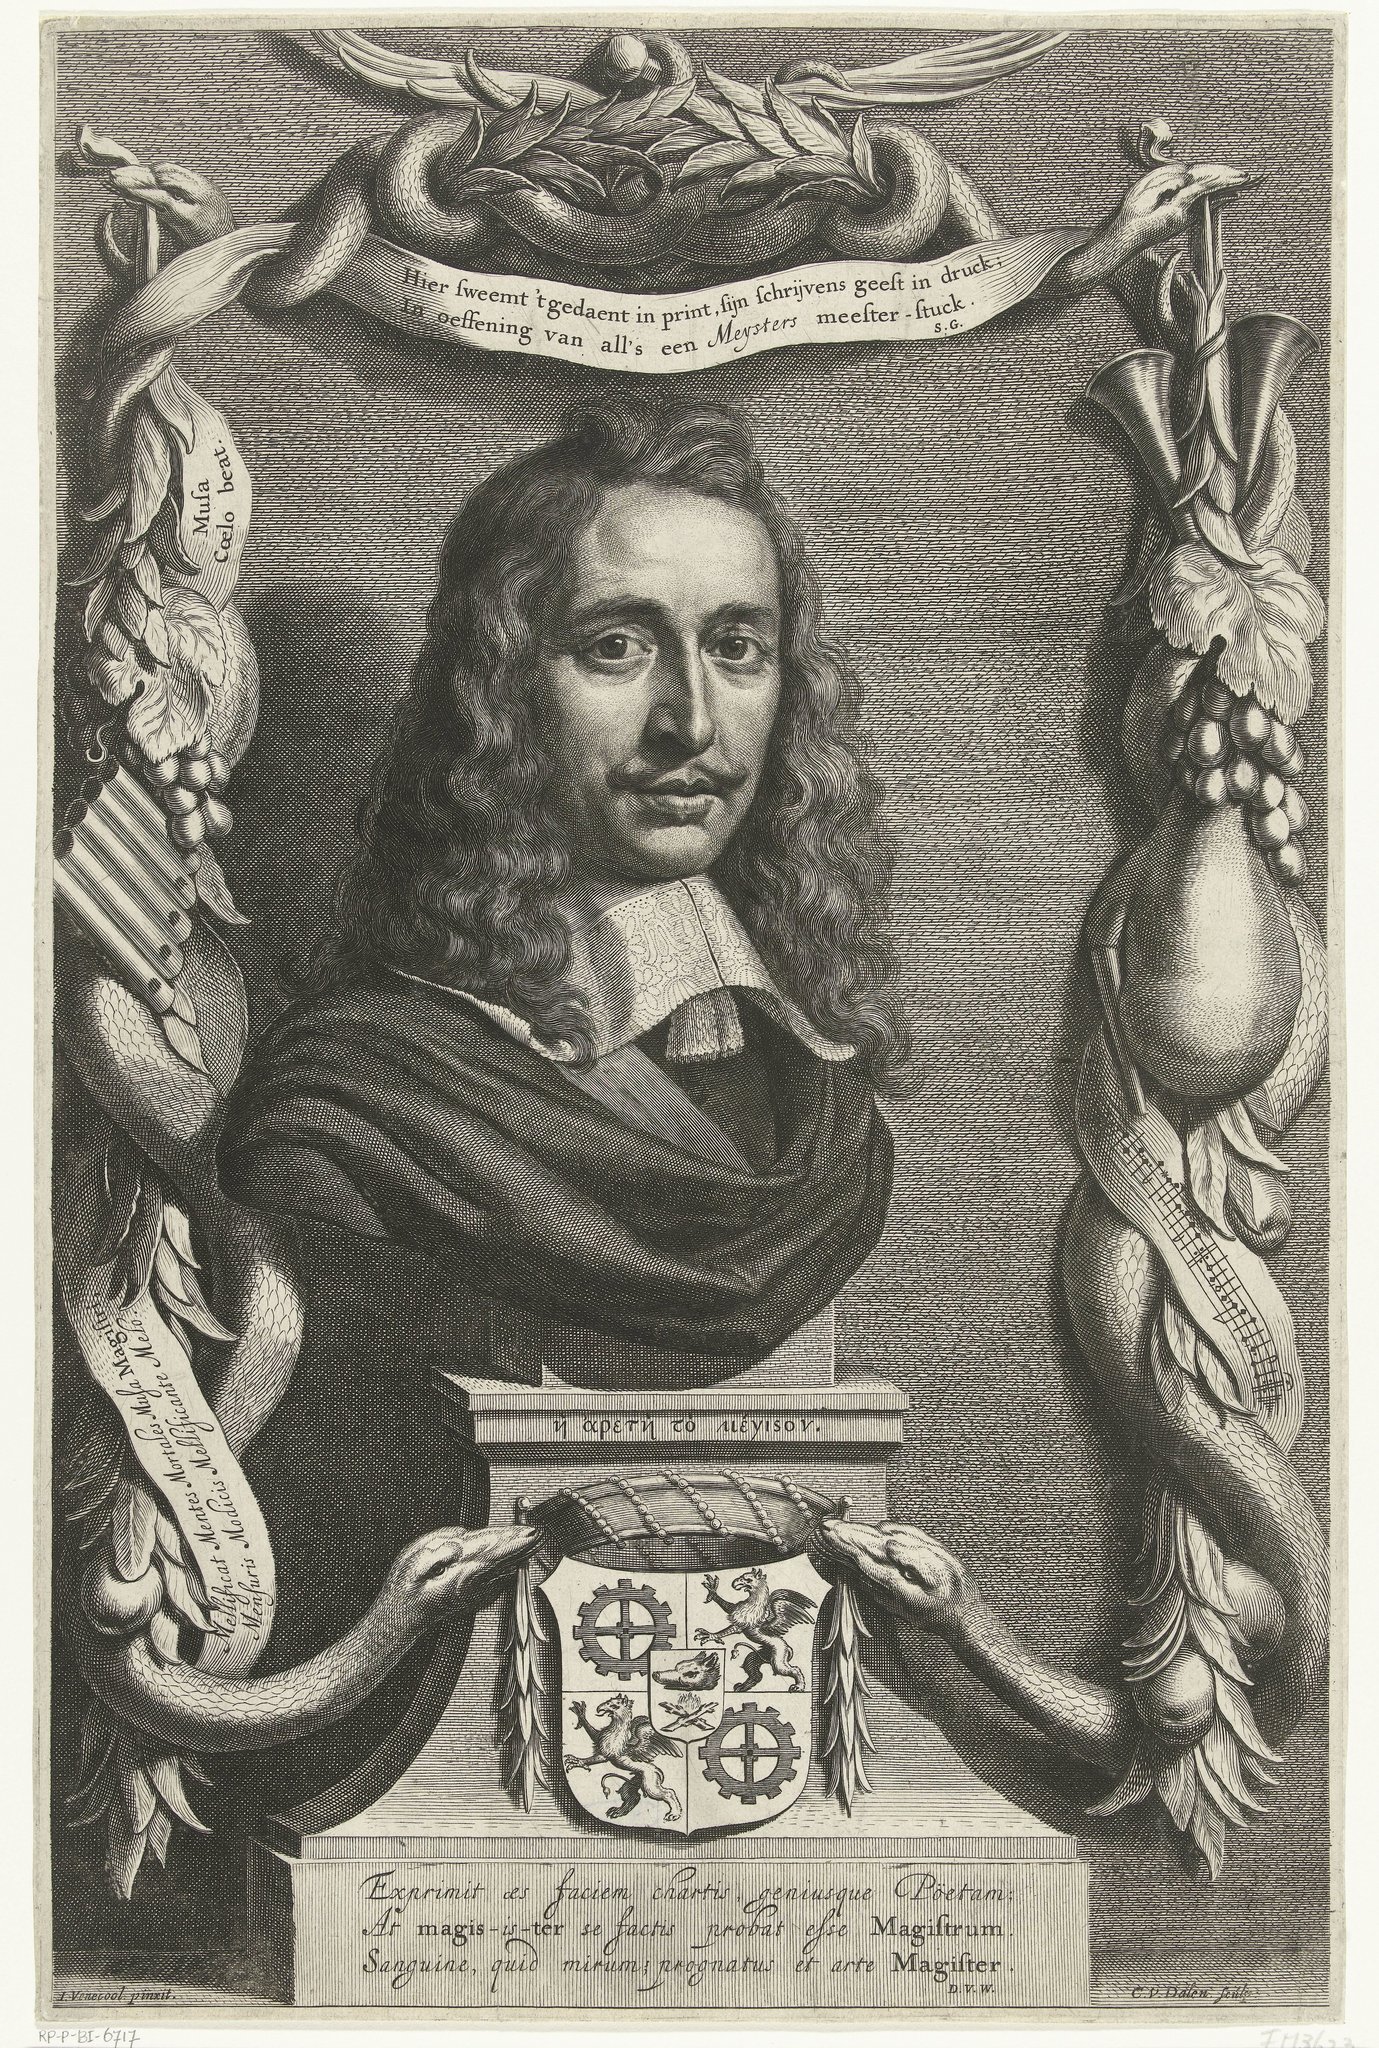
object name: print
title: Portret van jonkheer Everard Meyster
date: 1648-1664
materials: paper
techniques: engraving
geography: amsterdam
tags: utrecht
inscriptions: collector's mark: Lugt 2228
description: Portret van jonkheer Everard Meyster, buste op sokkel met zijn wapen. Binnen omlijsting van guirlandes samengesteld uit kronkelende slangen, lauwerkrans, muziekinstrumenten en fruit. In het vlechtwerk is een lint met Latijnse en Nederlandse verzen en een notenbalk opgenomen. Op de sokkel staat een Grieks opschrift.